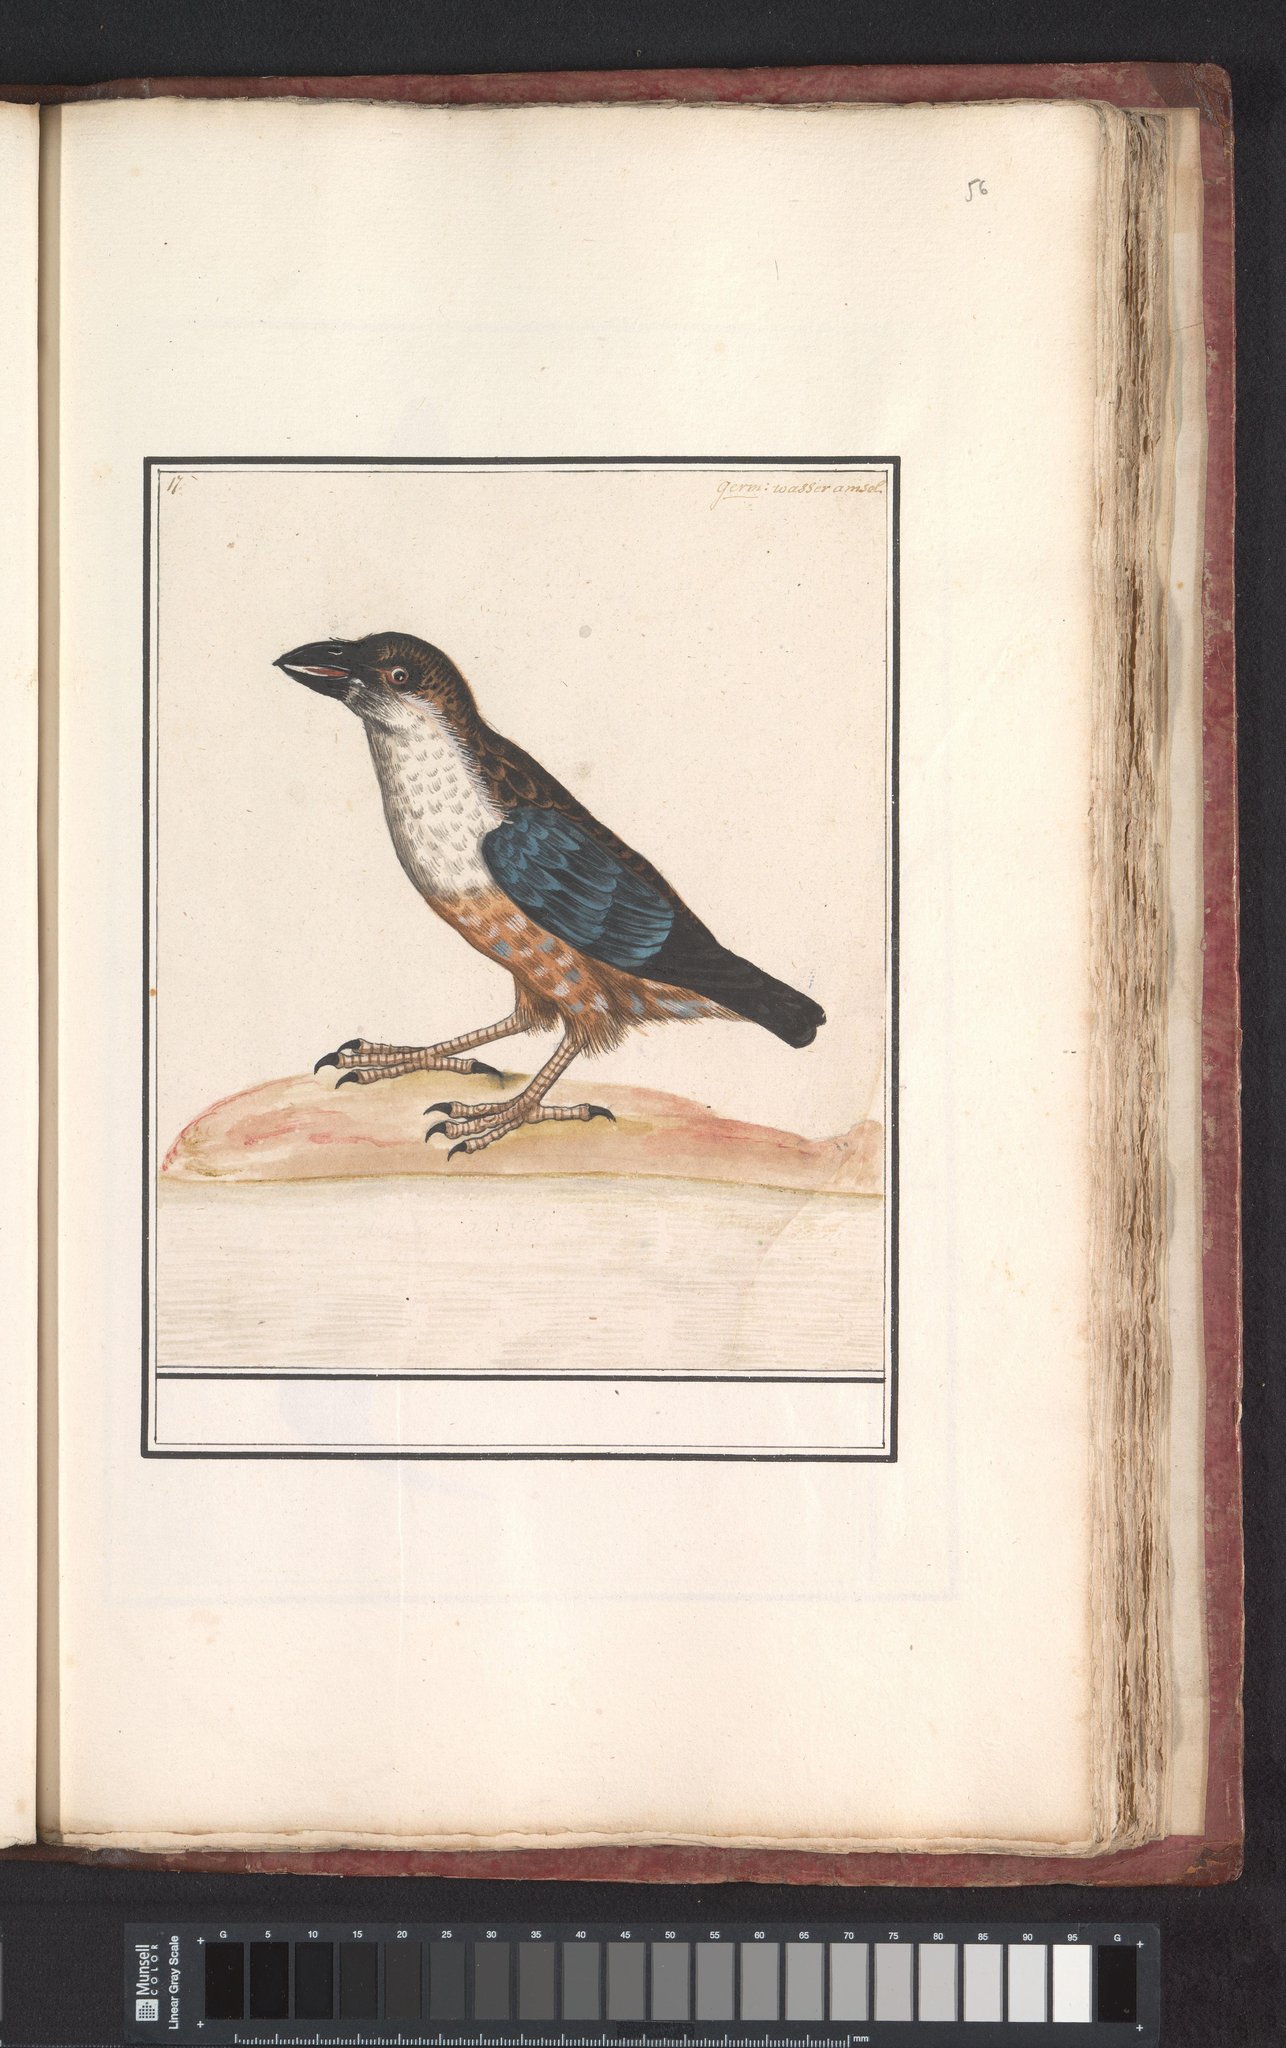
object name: drawing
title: White-throated Dipper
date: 1596-1610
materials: chalk, paint, ink, paper, pencil, watercolor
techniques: brush, pen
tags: shore-birds and wading-birds: white-throated dipper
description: Waterspreeuw. Genummerd linksboven: 17. Rechts de Duitse naam. Onderdeel van het derde album met tekeningen van vogels. Vijfde van twaalf albums met tekeningen van dieren, vogels en planten bekend rond 1600, gemaakt in opdracht van keizer Rudolf II. Met toelichting in Nederlands, Latijn en Frans.